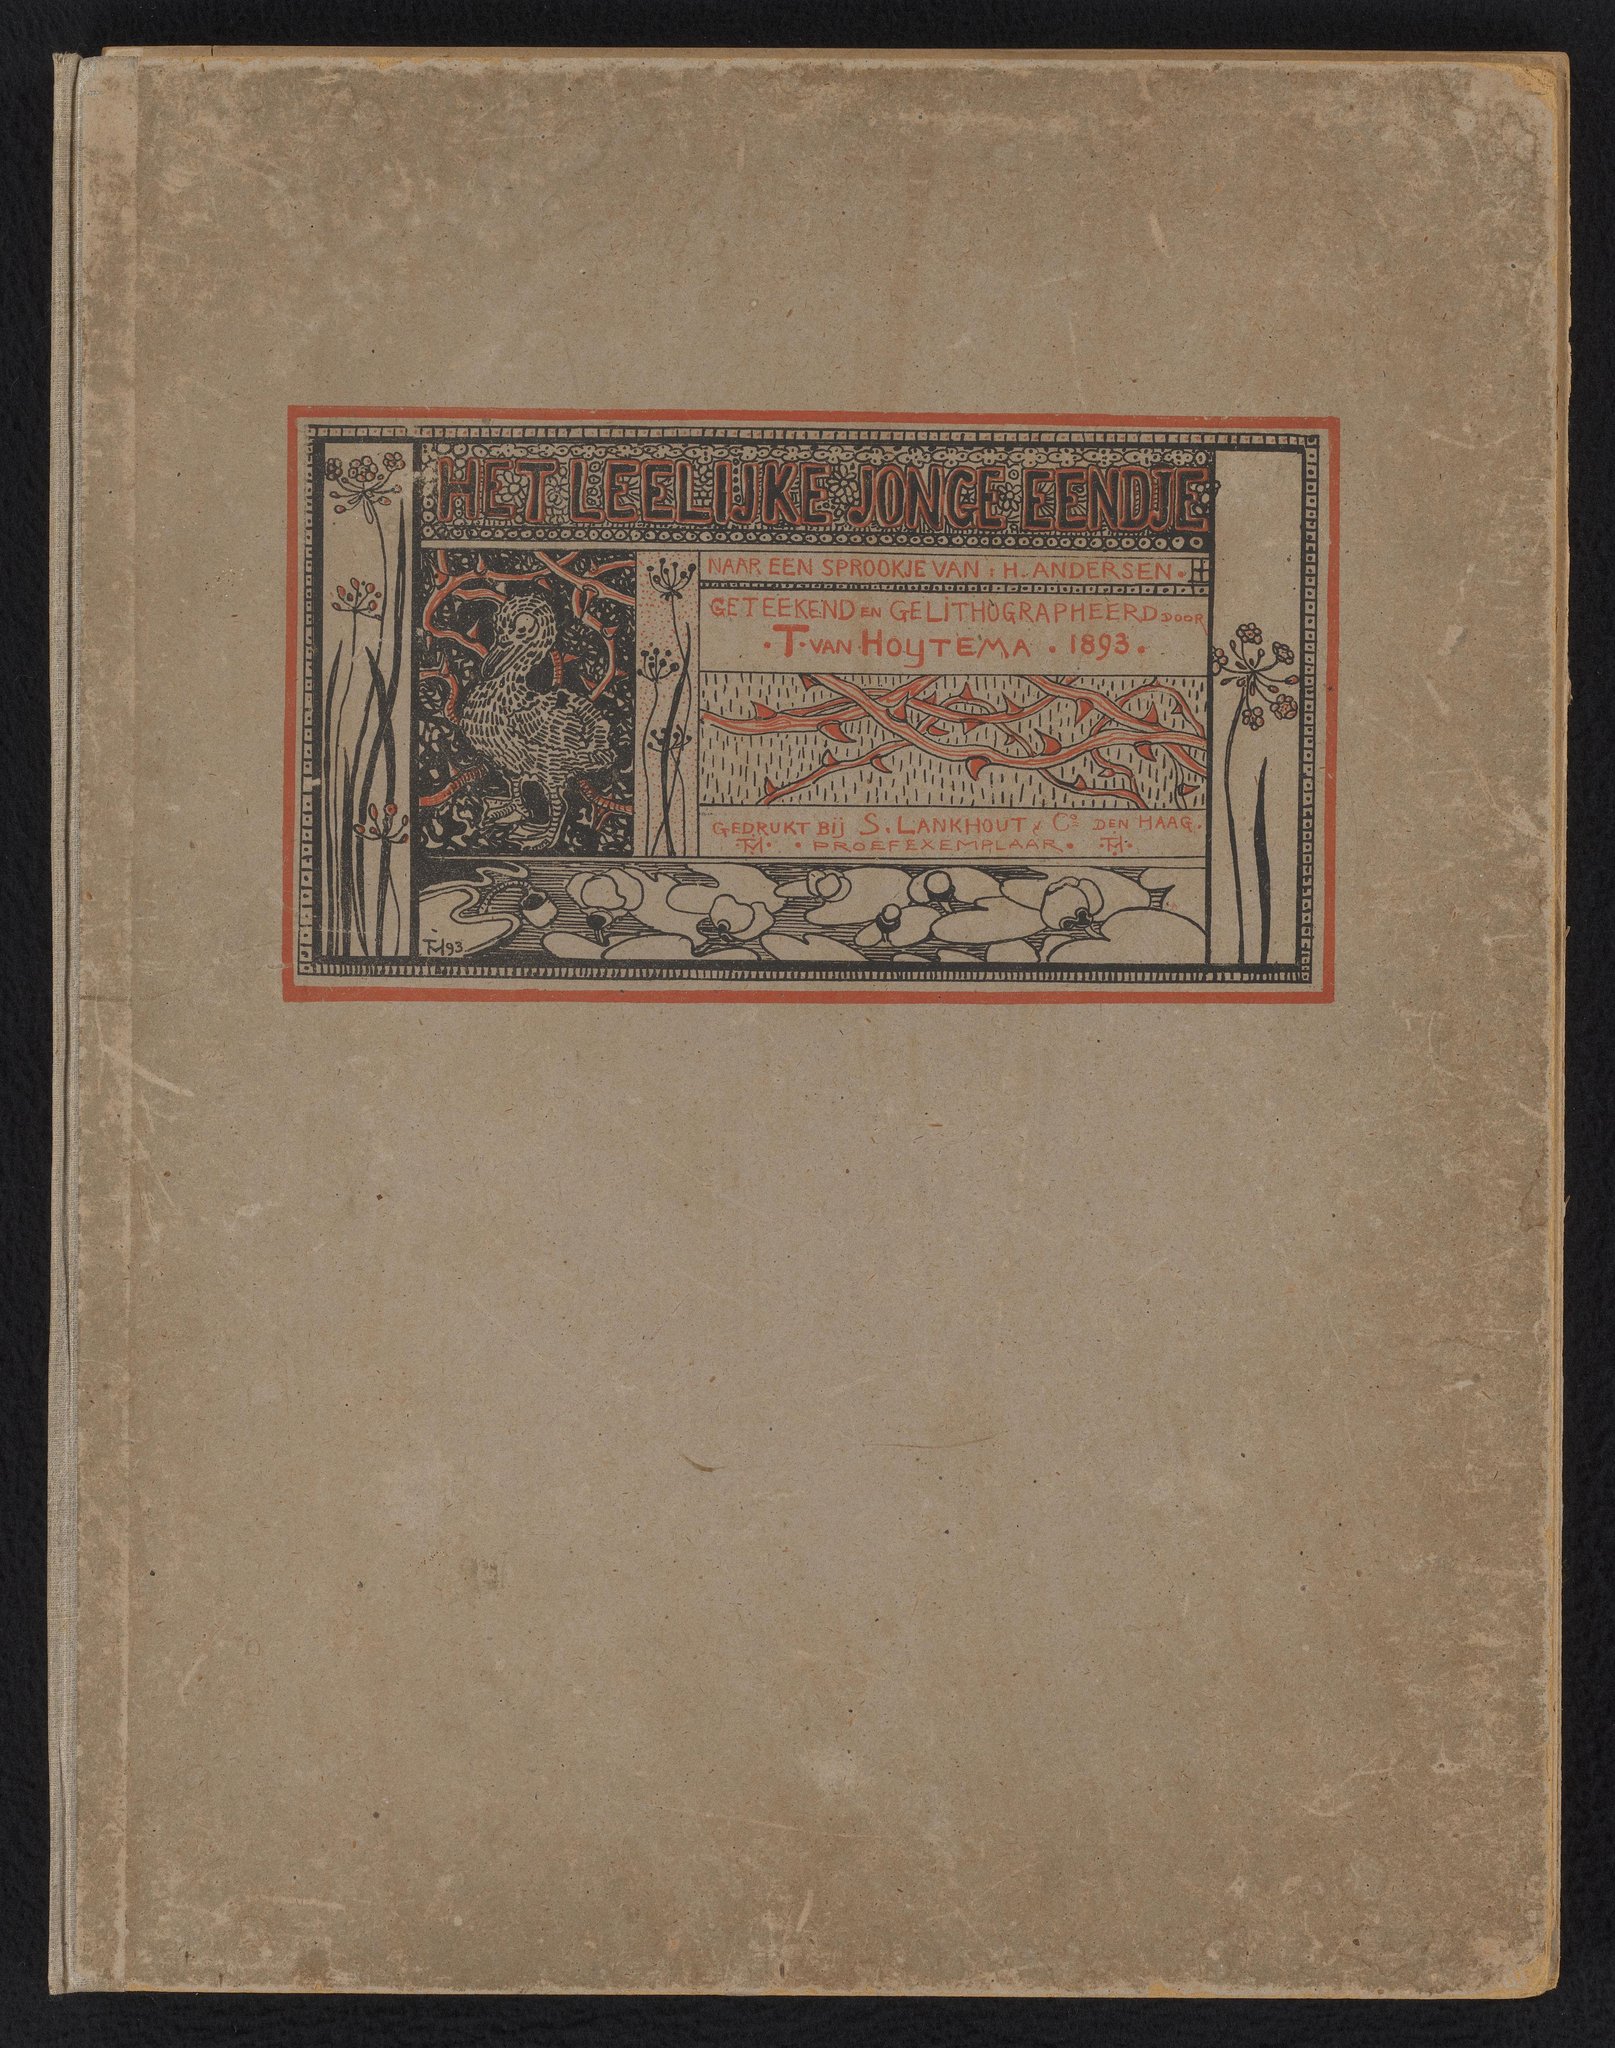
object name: prentrecueil, prentenalbum, prentalbum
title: Het leelijke jonge eendje, naar een sprookje van H. Andersen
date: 1893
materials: cardboard, linen, paper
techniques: bookbinding, letterpress printing, lithograph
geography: the hague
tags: tales and fairy tales, ducks (domestic waterbirds), water-birds: duck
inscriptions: collector's mark: Lugt 2228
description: Proefexemplaar, als aangegeven op het voorplat. De tekst is hier nog in handschrift op de steen gezet en in zwart gedrukt. In de handelseditie wordt dit vervangen door tekst in drukletters.